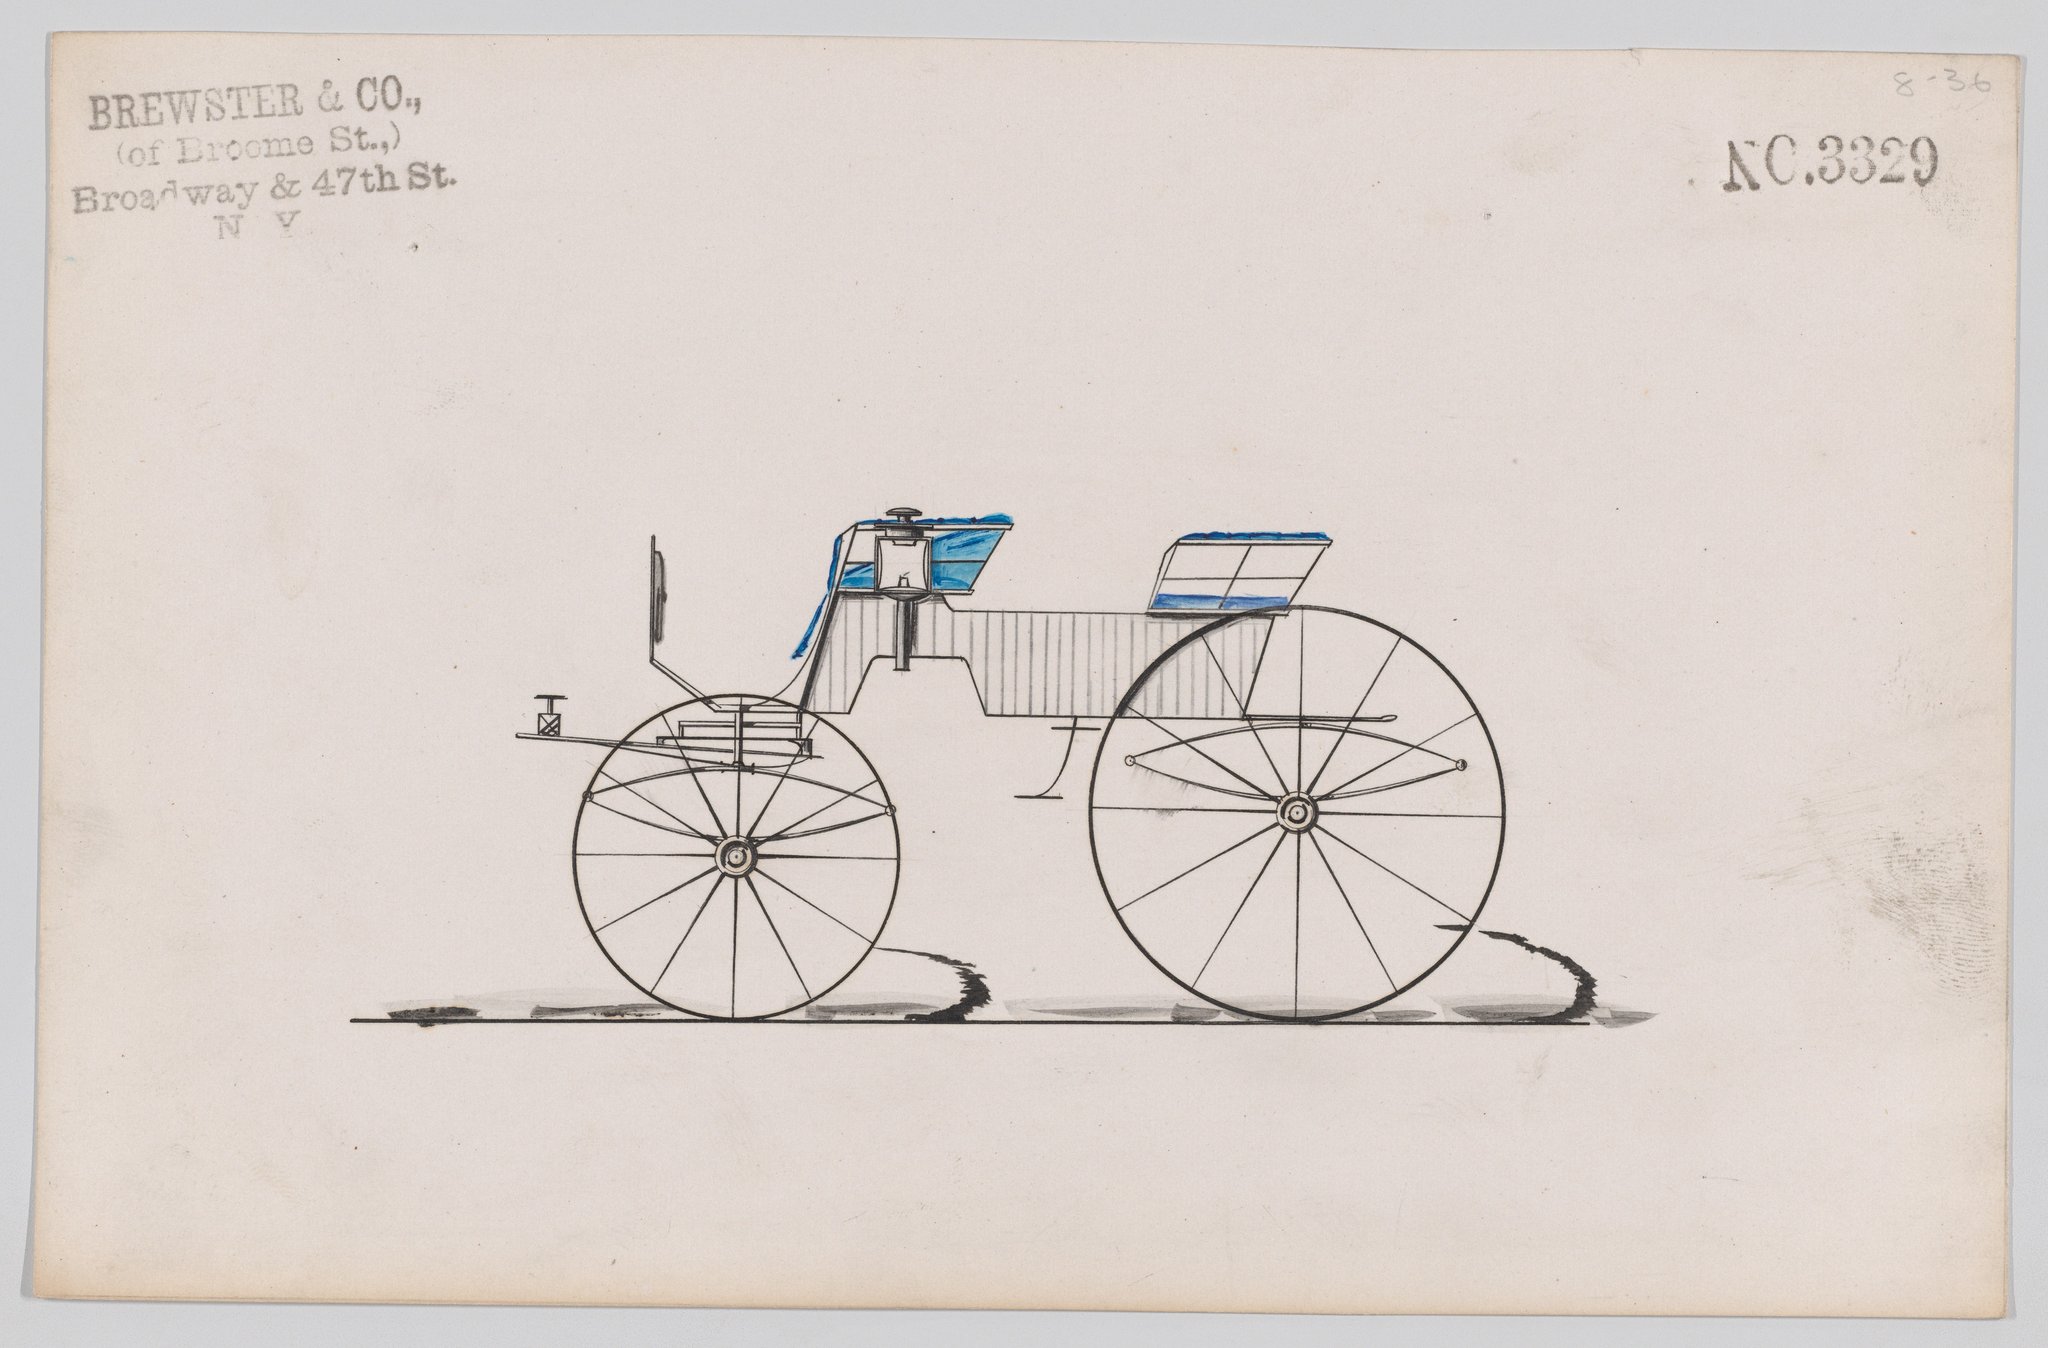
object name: drawing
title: Design for 4 seat Phaeton, no top, no. 3329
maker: brewster & co.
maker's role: manufacturer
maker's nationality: american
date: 1877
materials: gouache, ink, watercolor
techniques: pen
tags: carriages